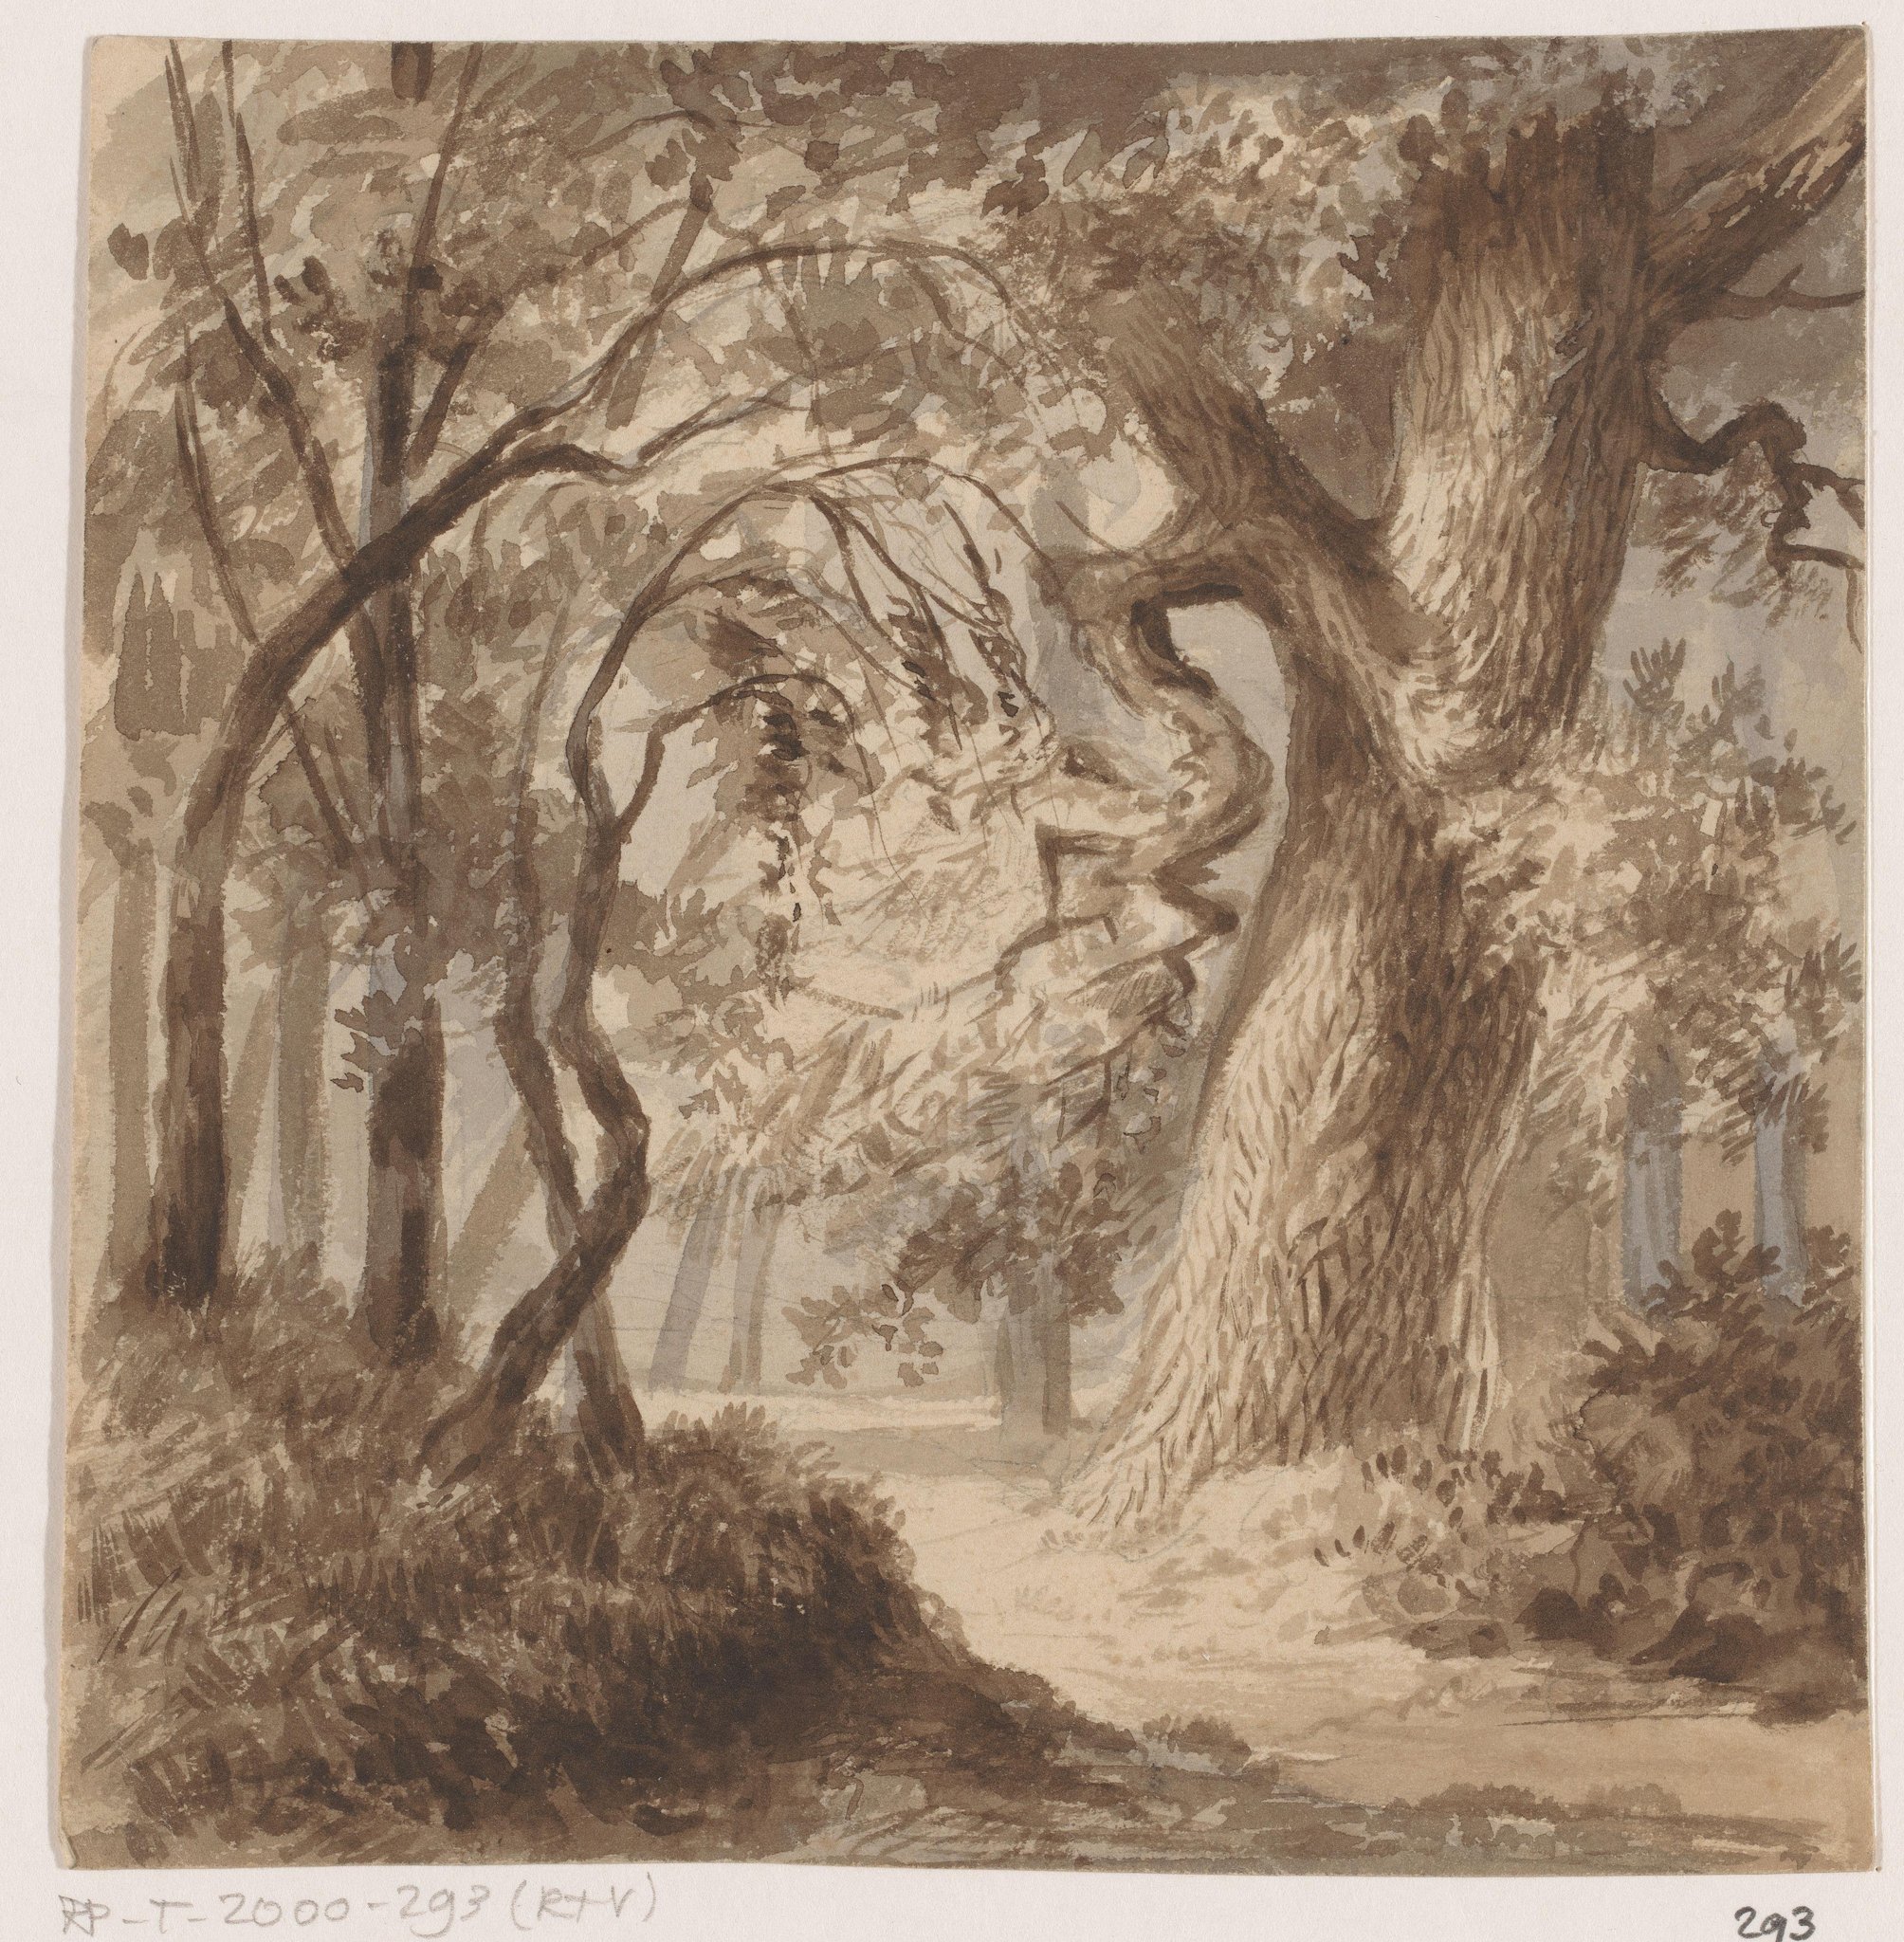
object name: drawing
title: Boslandschap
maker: johannes tavenraat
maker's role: draughtsman, painter, print maker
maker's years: 1809-1881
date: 1840-1880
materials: ink, paper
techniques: brush, pen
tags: forest, wood